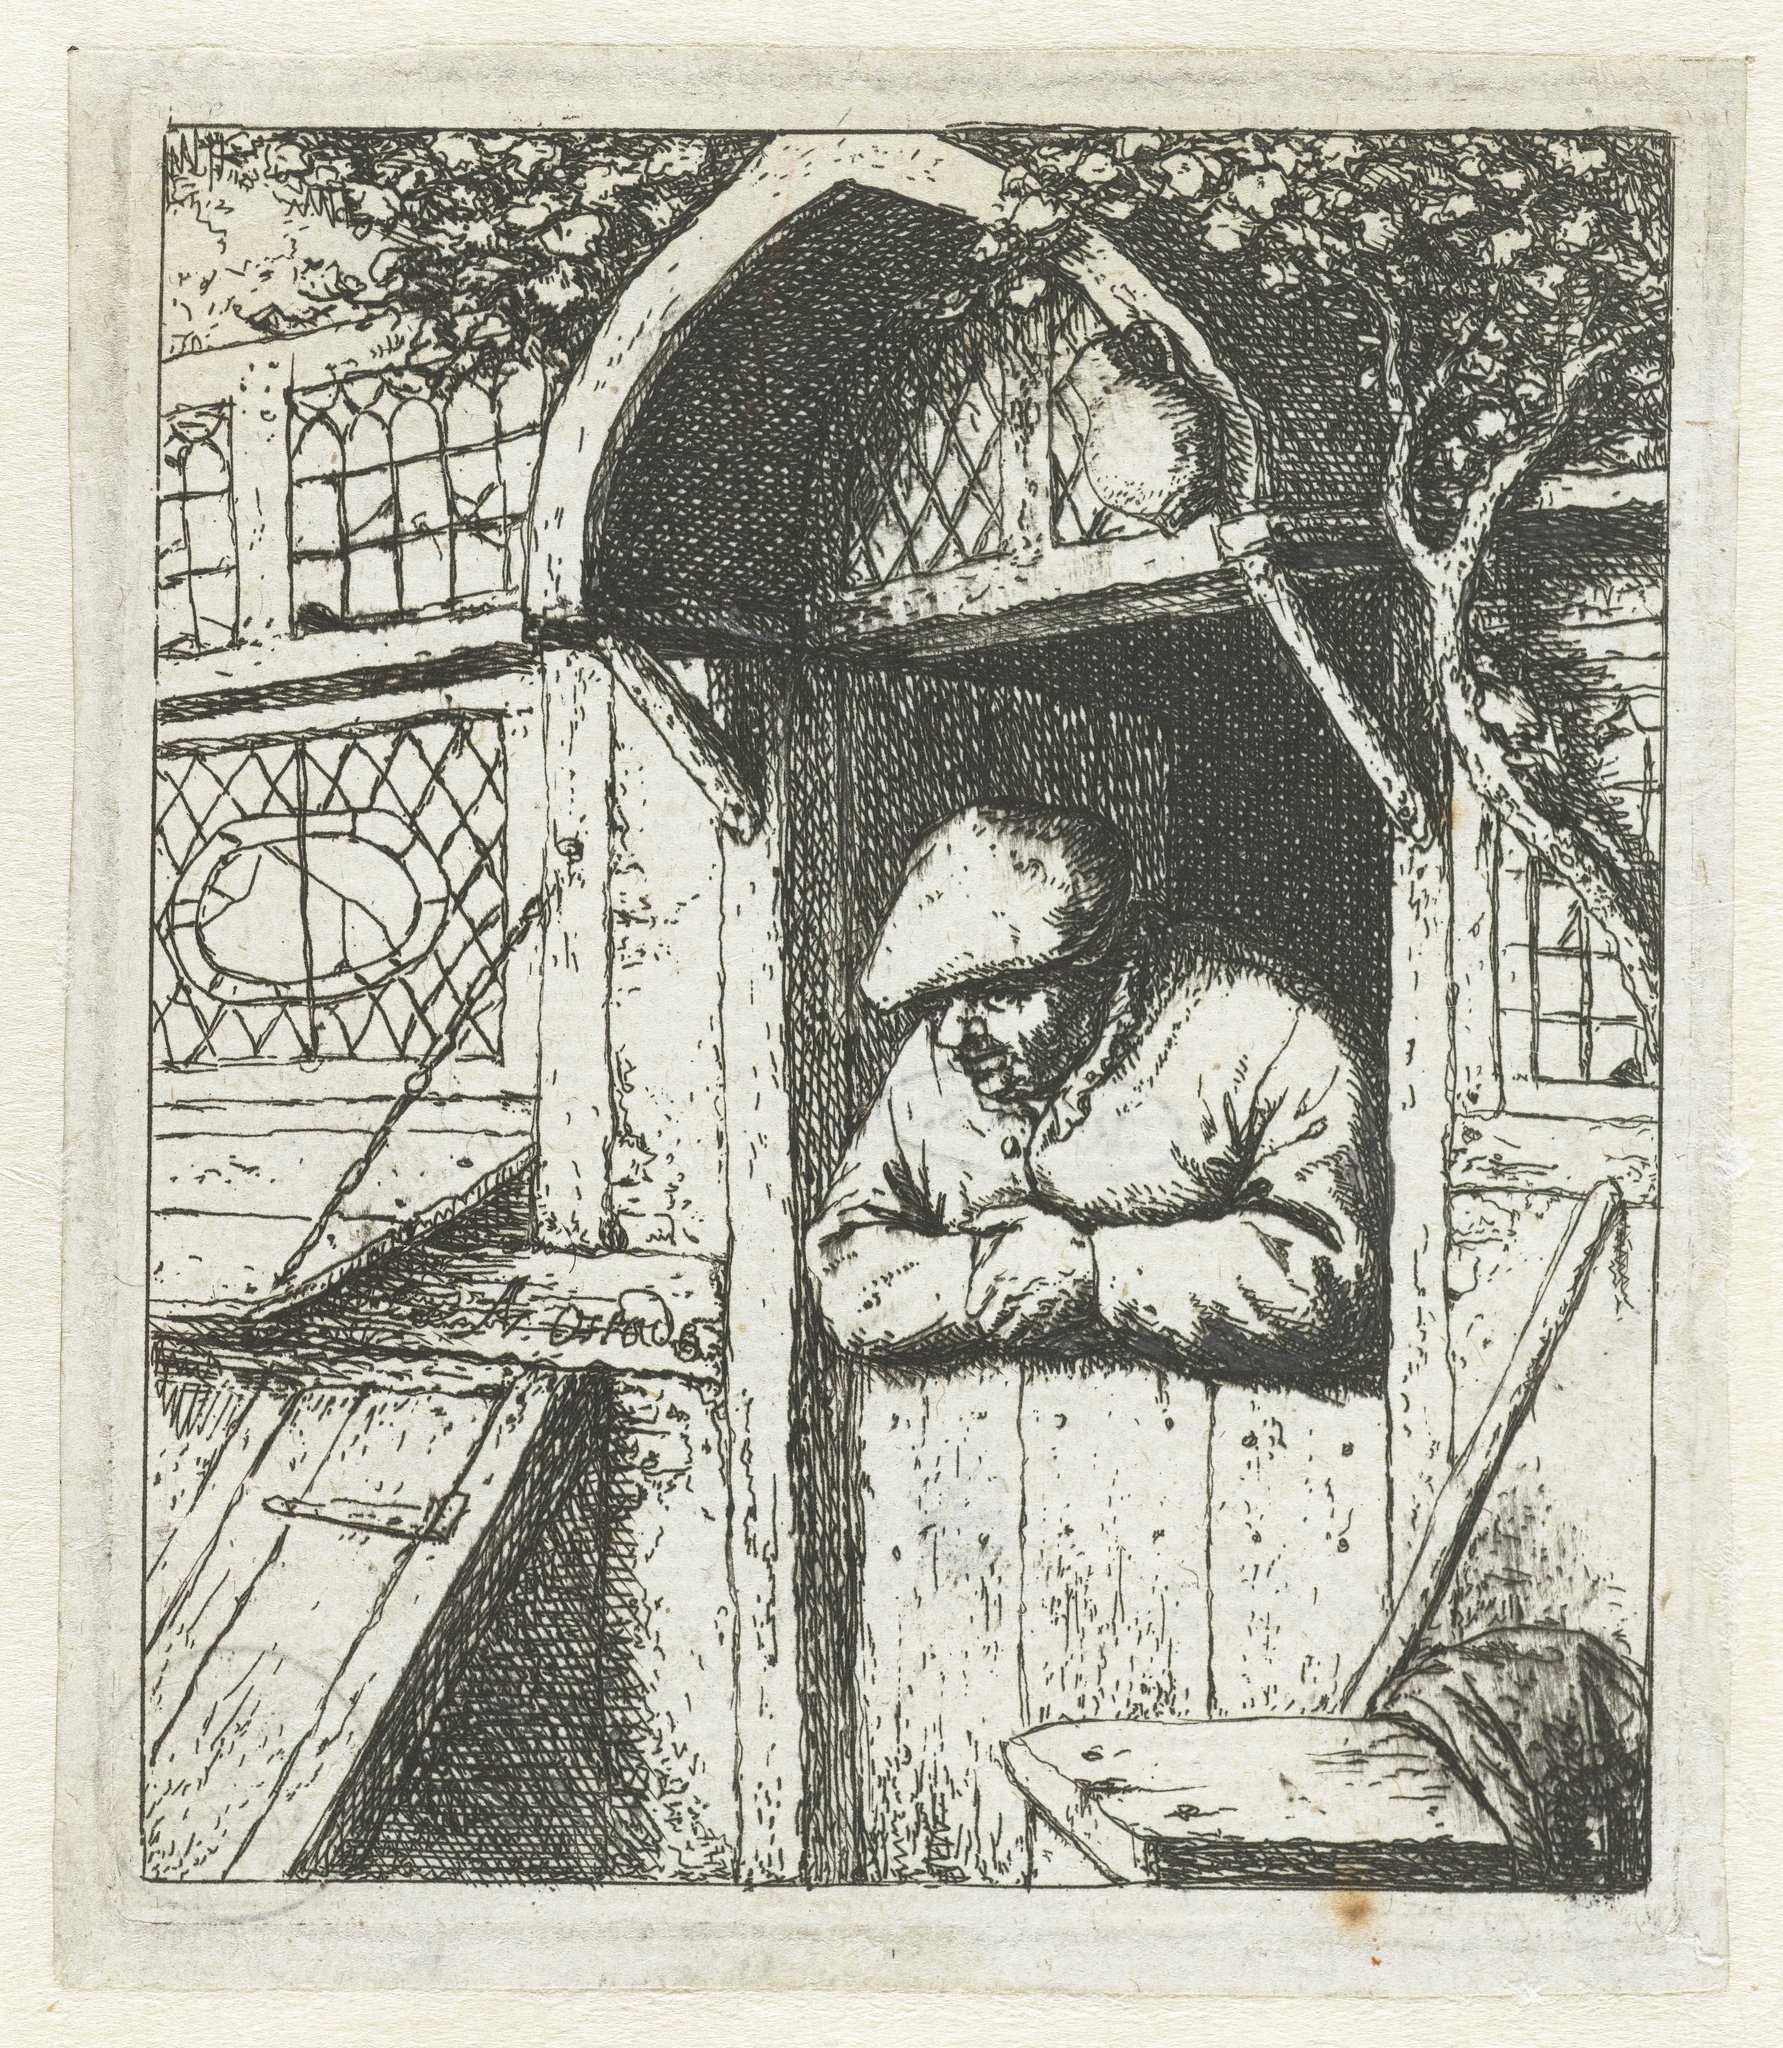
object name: print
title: Boer leunend op onderdeur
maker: adriaen van ostade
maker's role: draughtsman, painter, print maker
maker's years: 1610-1685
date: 1651-1655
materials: paper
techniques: etching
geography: haarlem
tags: divided door, upper part opened, male sex; man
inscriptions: collector's mark: Lugt 2760, collector's mark: Lugt 514, collector's mark: Lugt 2228a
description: op verso onjuist inventarisnummer vermeld